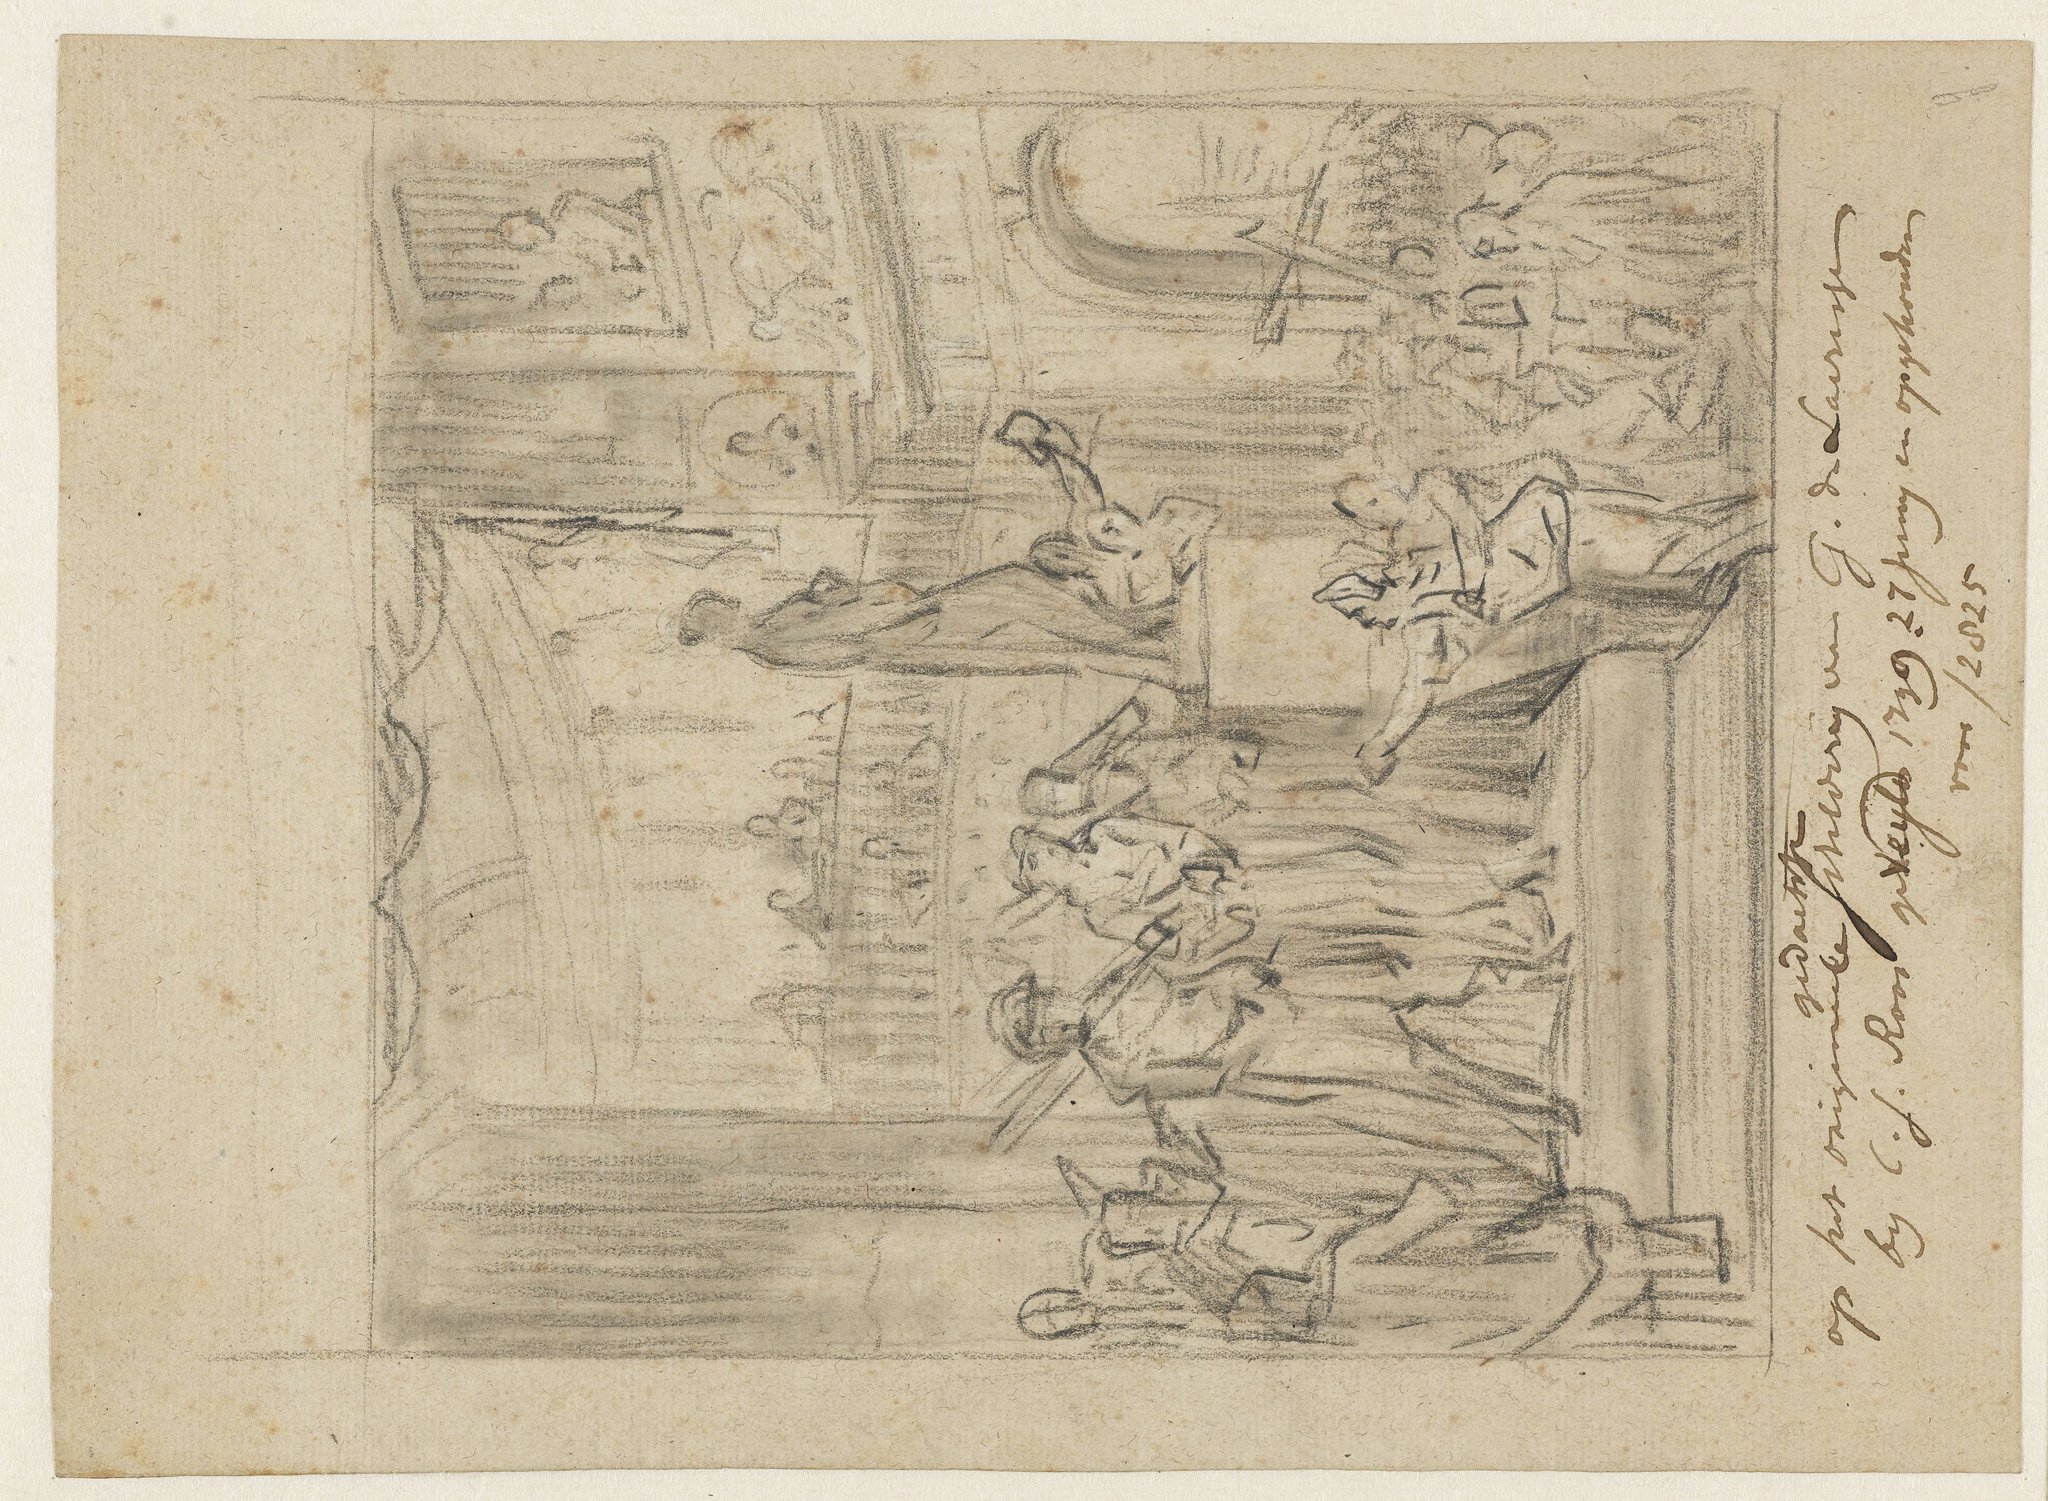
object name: drawing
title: Ecce Homo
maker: jurriaan andriessen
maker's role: draughtsman, painter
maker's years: 1742-1819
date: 1799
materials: chalk, paper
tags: picture, painting, pilate showing christ to the people, 'ostentatio christi', 'ecce homo' (john 19:4-6)